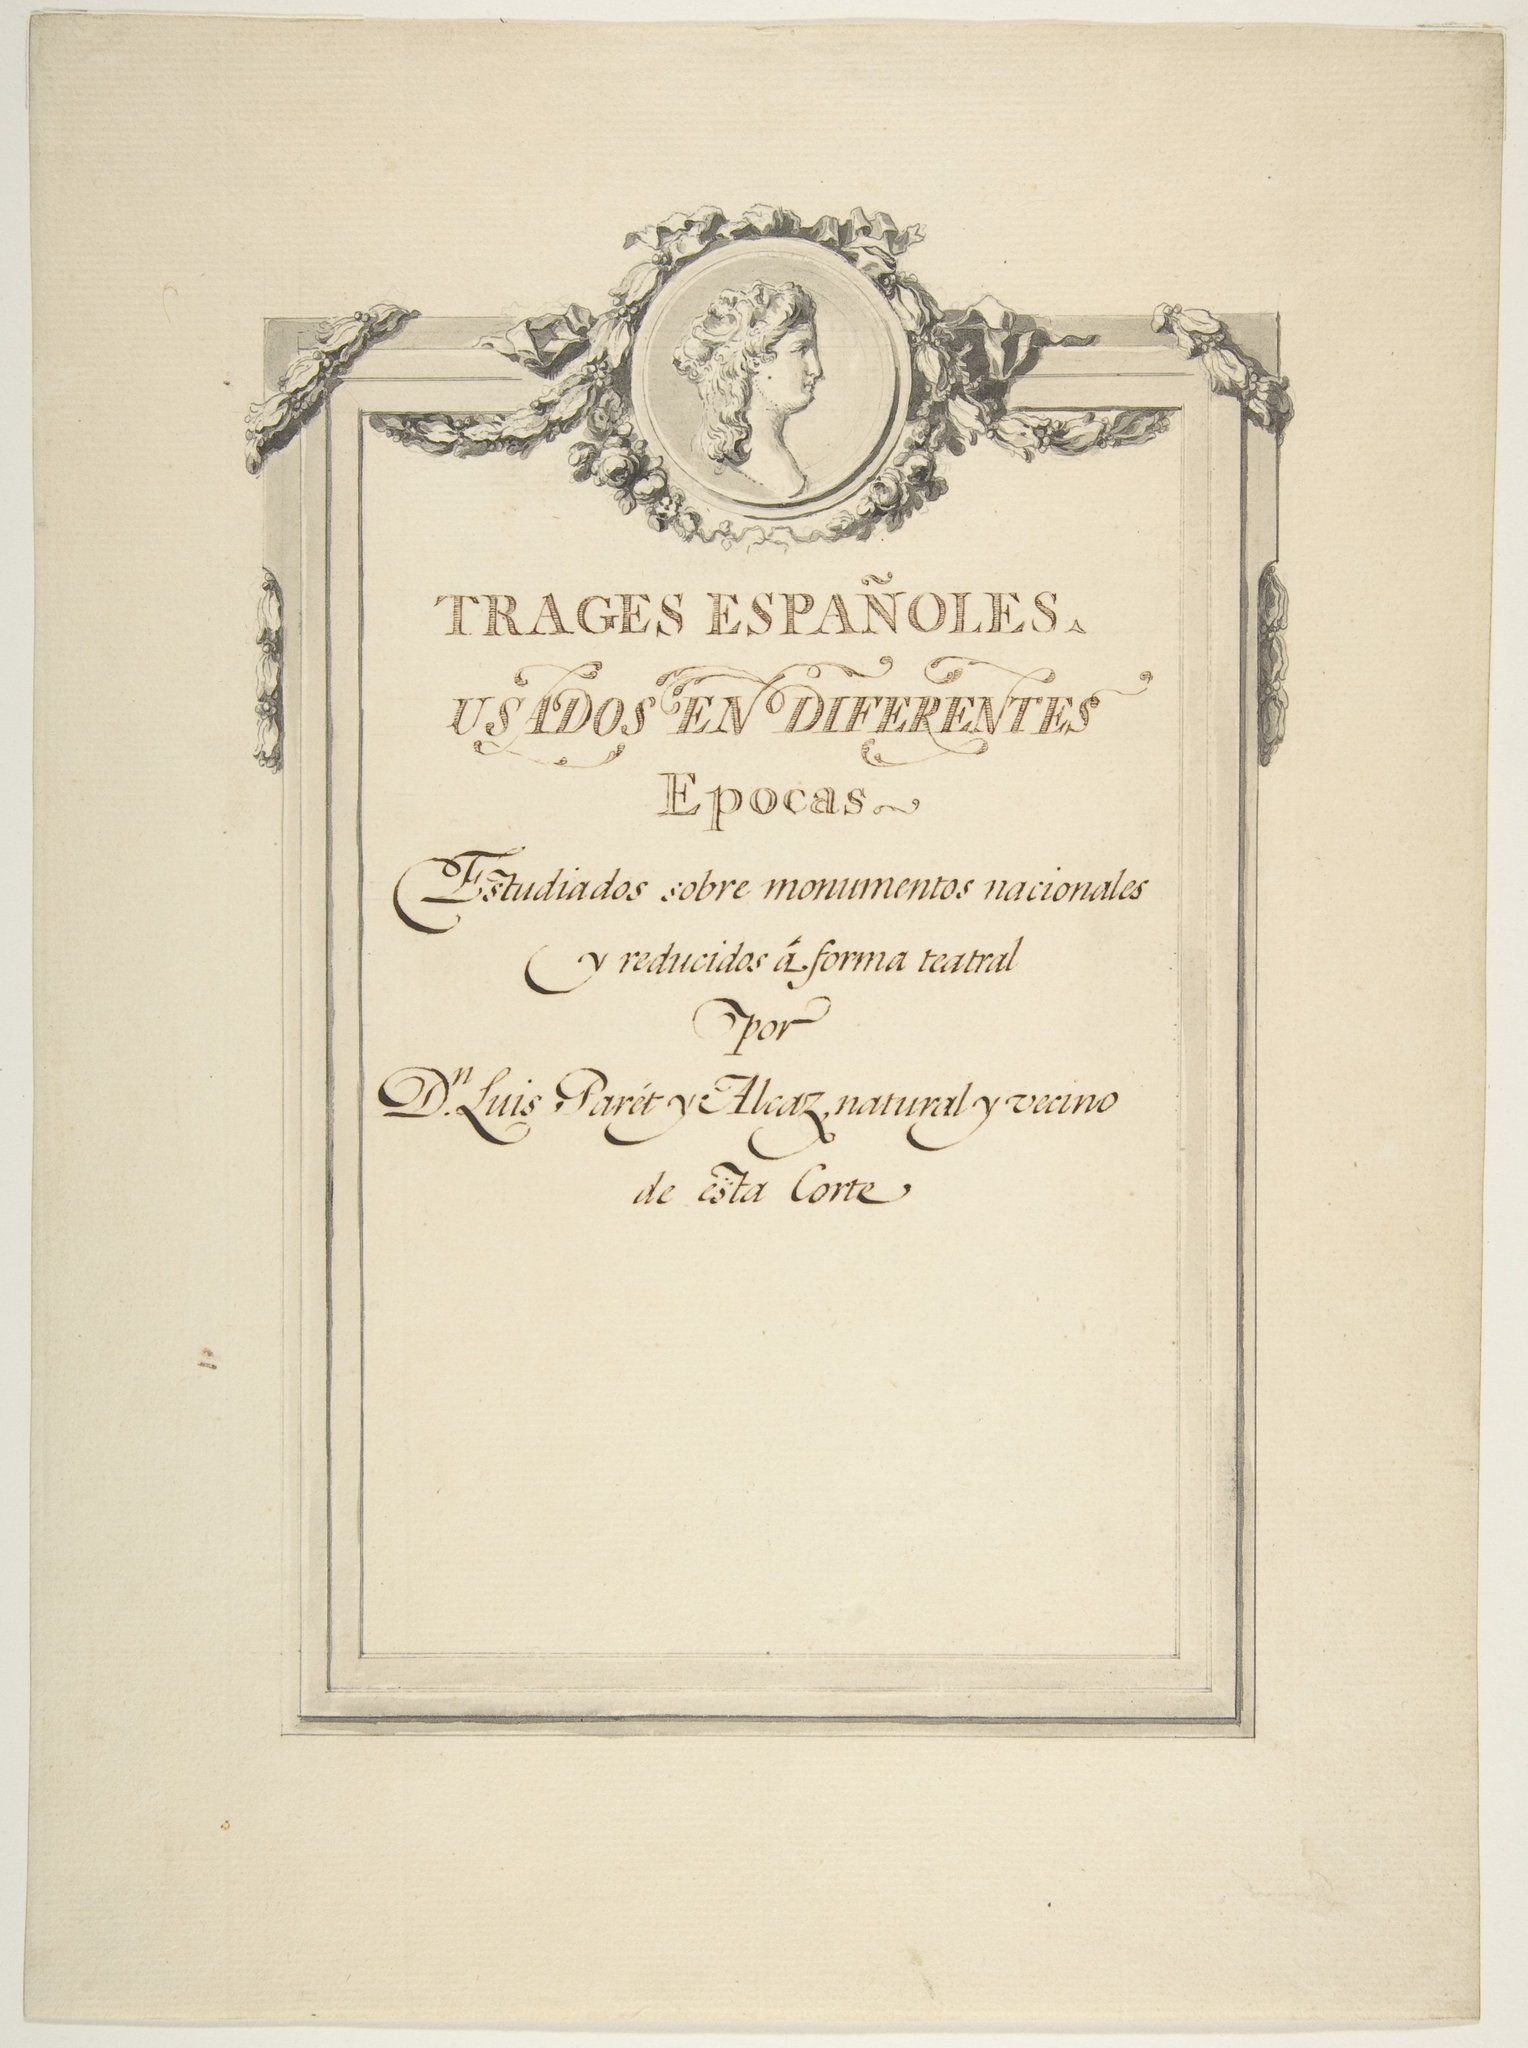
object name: drawing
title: Frontispiece for the collection 'Trages españoles usados en diferentes epocas'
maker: luis paret y alcázar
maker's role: artist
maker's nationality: spanish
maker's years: 1746-1799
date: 1798-1799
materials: chalk, ink, paper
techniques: brush, pen, wash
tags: profiles,women